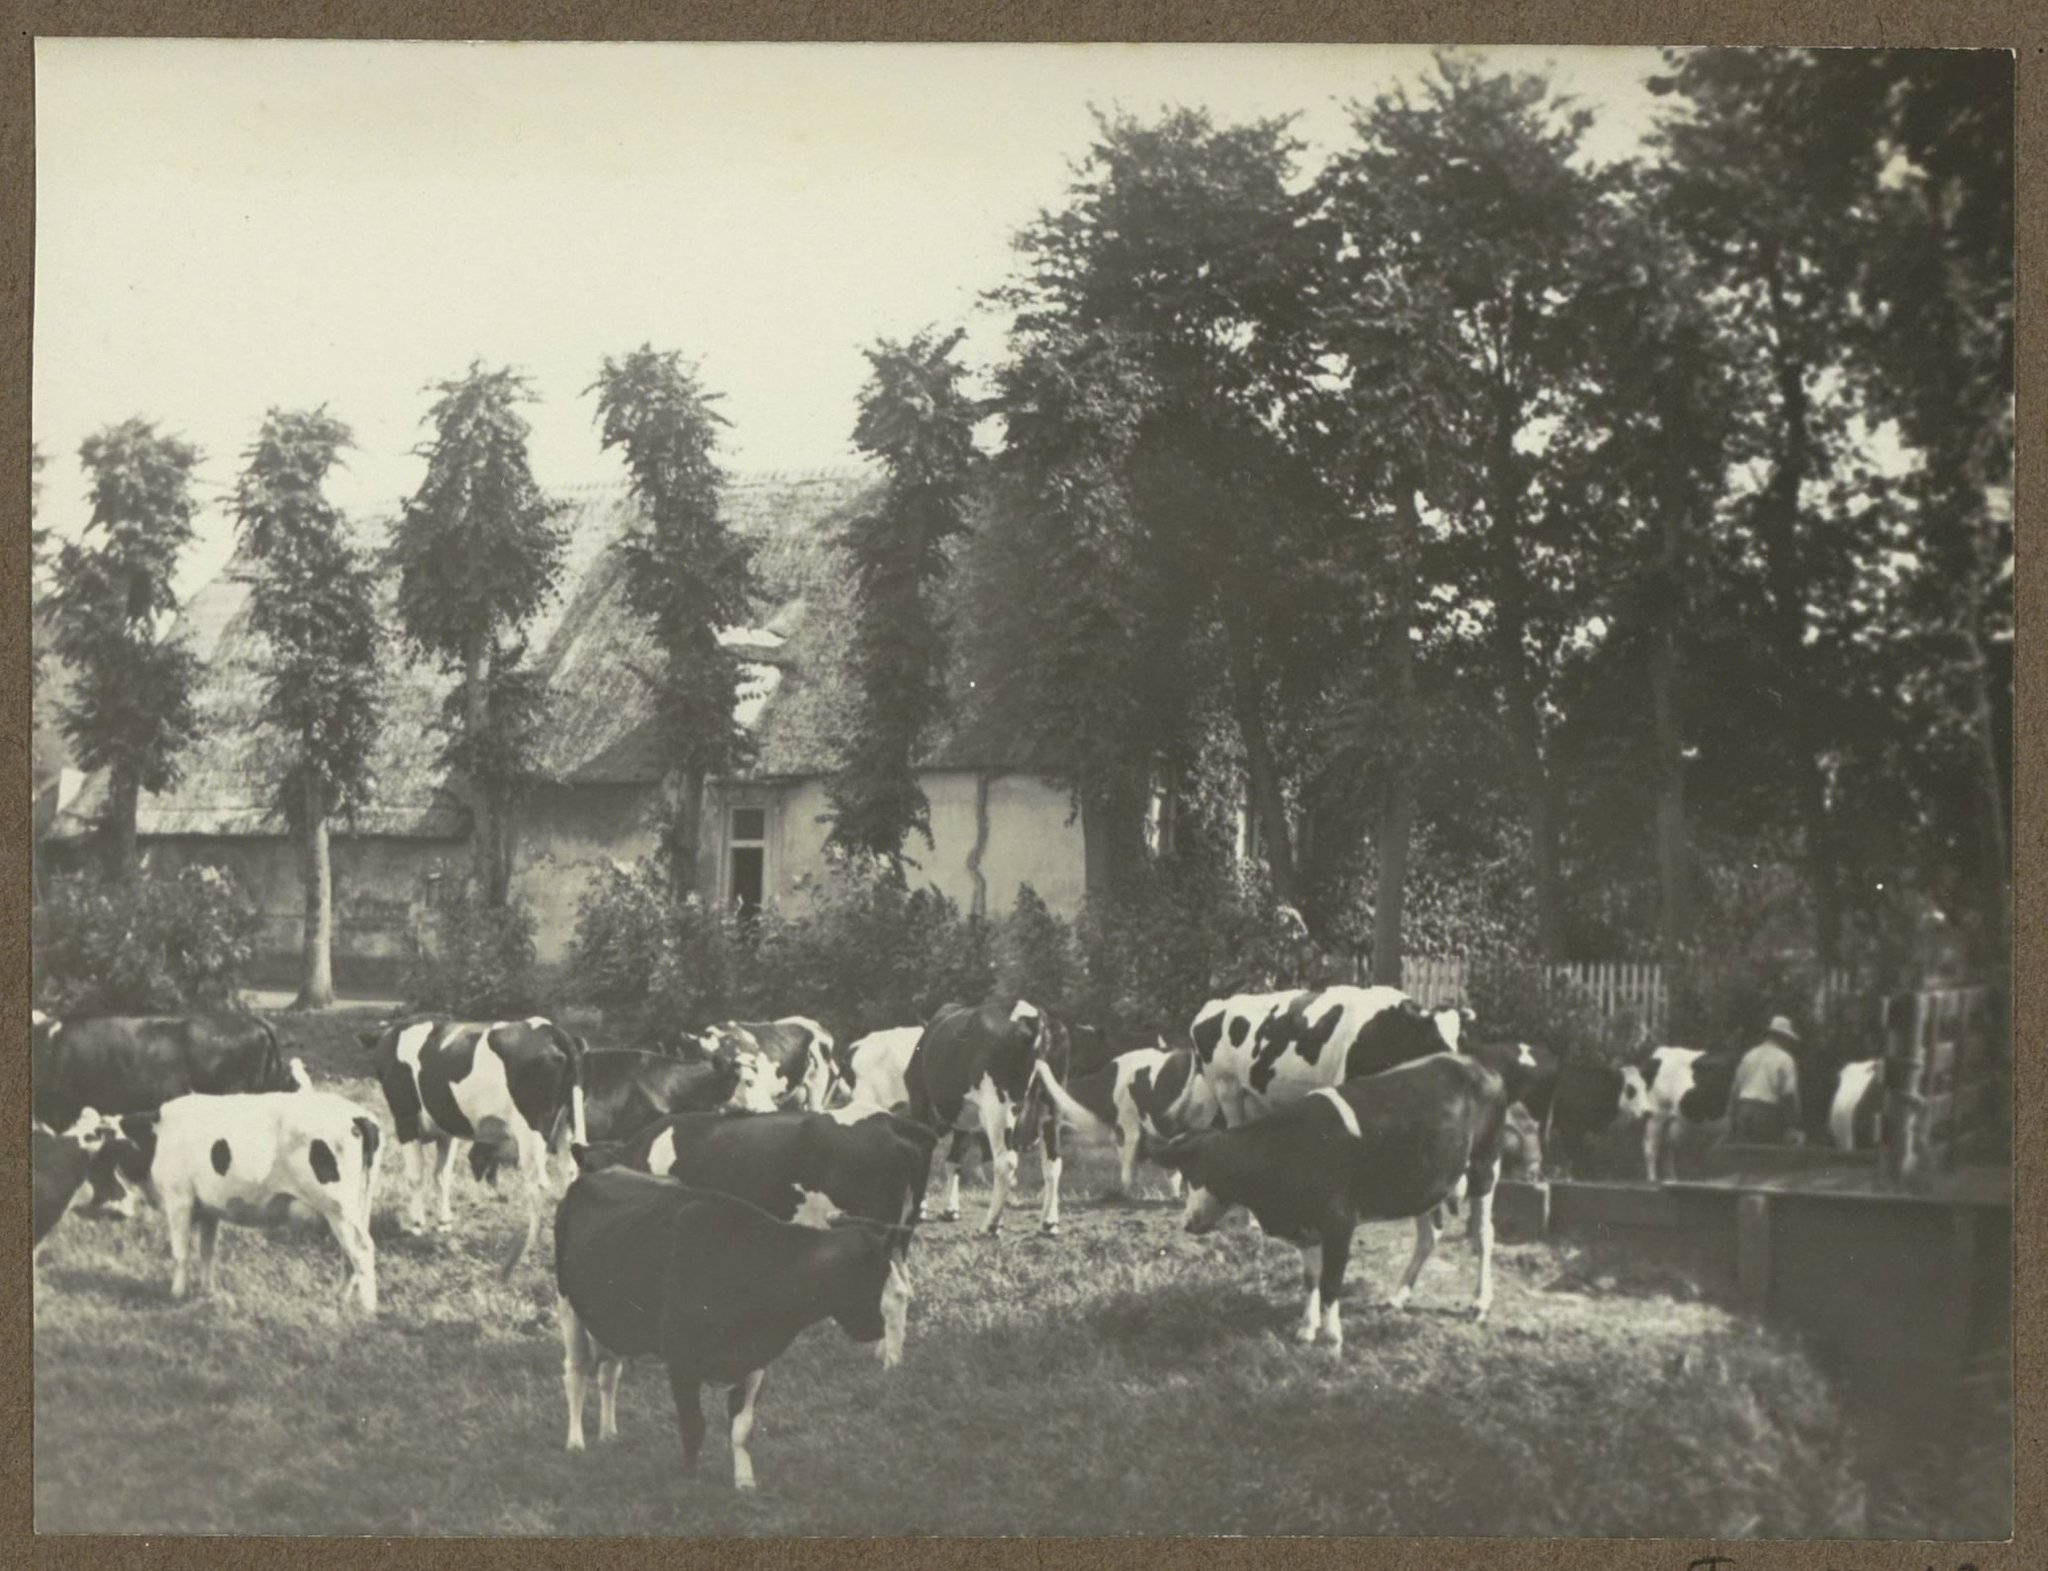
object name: photograph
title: Koeien voor boerderij 'Ken u zelven' aan de Amstelveenseweg 537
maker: Anonymous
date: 1910-1930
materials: paper, photographic support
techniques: gelatin silver print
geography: north holland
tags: cow, farm or solitary house in landscape, farm (building)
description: Onderdeel van Album met foto's van Amsterdam en omgeving.